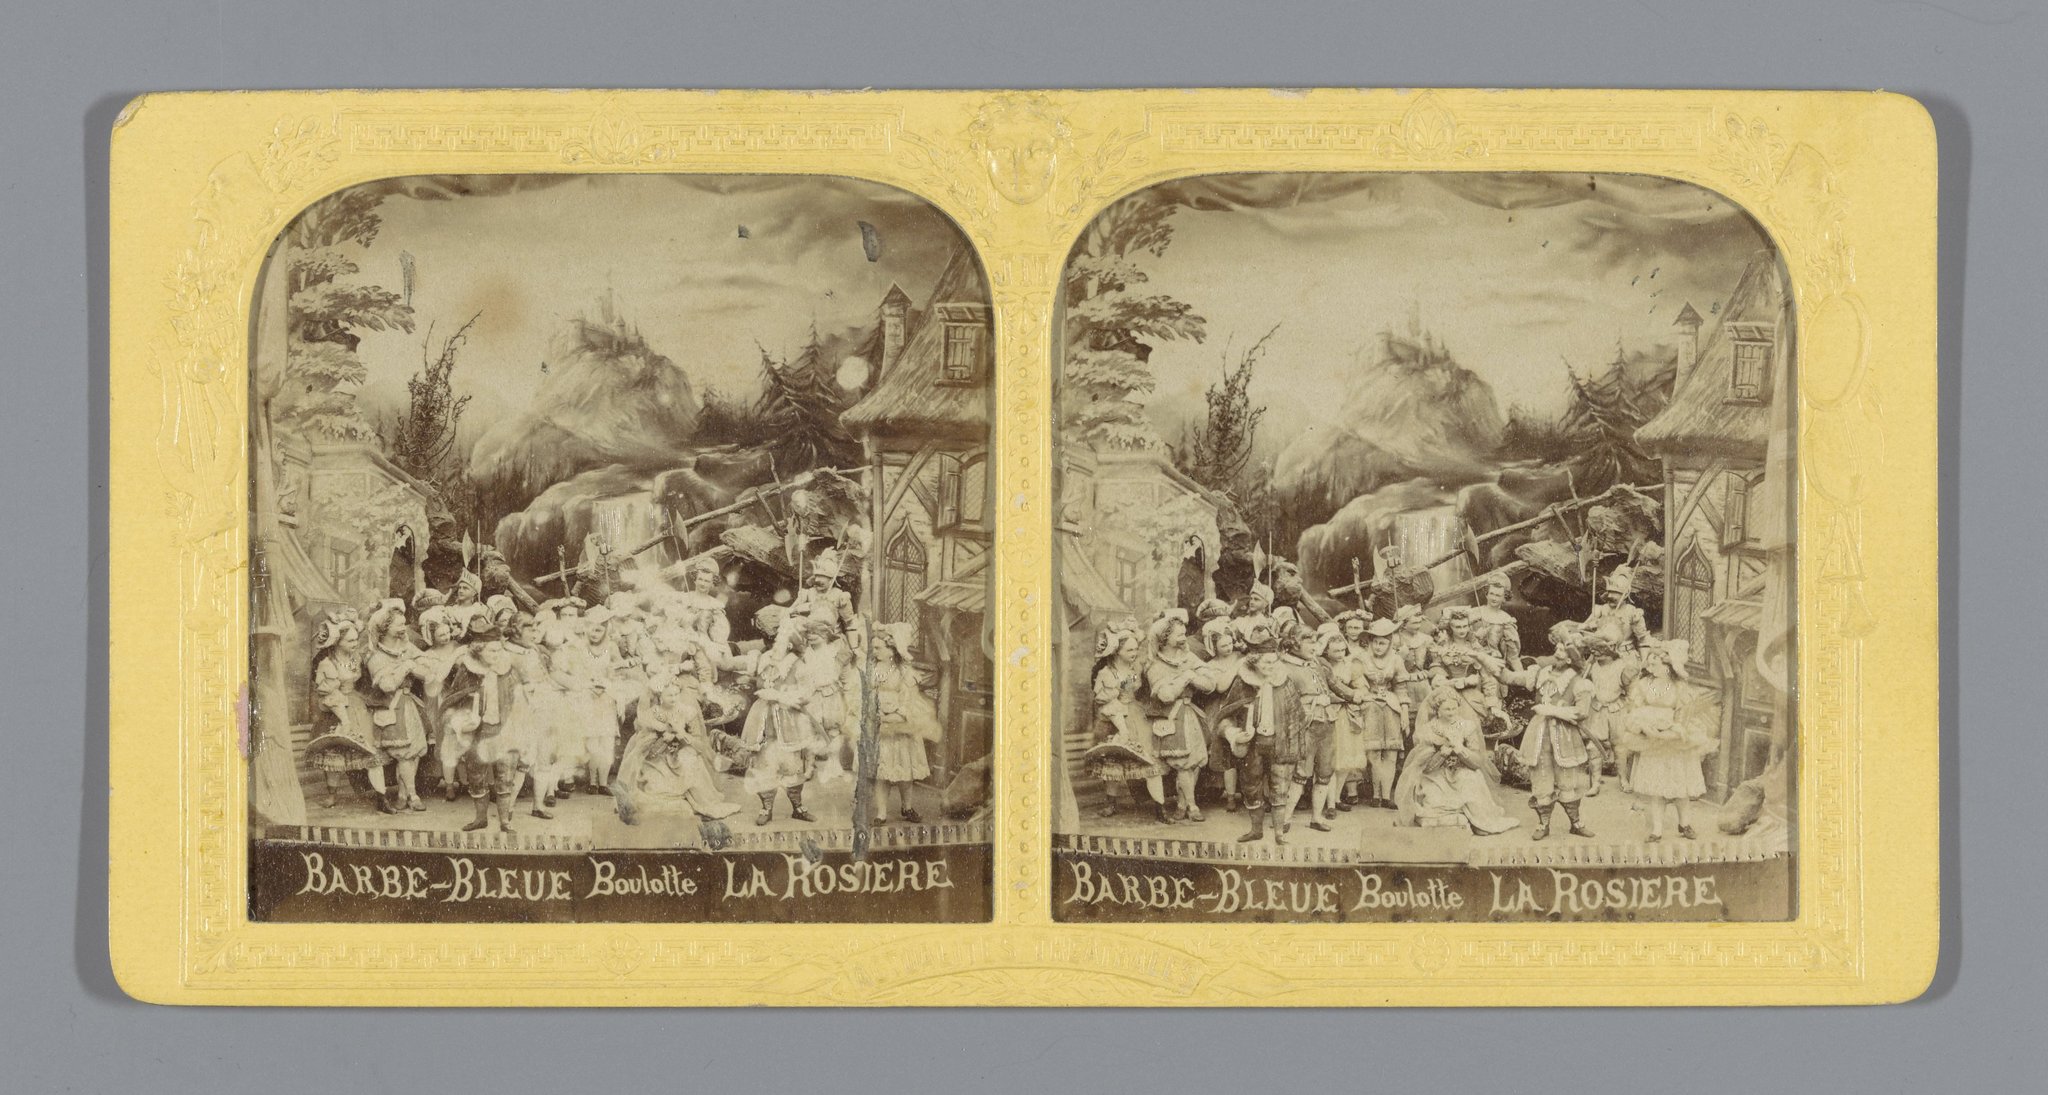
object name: stereograph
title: Stereofoto van het theater in Parijs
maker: Anonymous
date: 1867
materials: cardboard, photographic support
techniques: albumen print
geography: paris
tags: group of actors, troupe; actors on the stage, paris